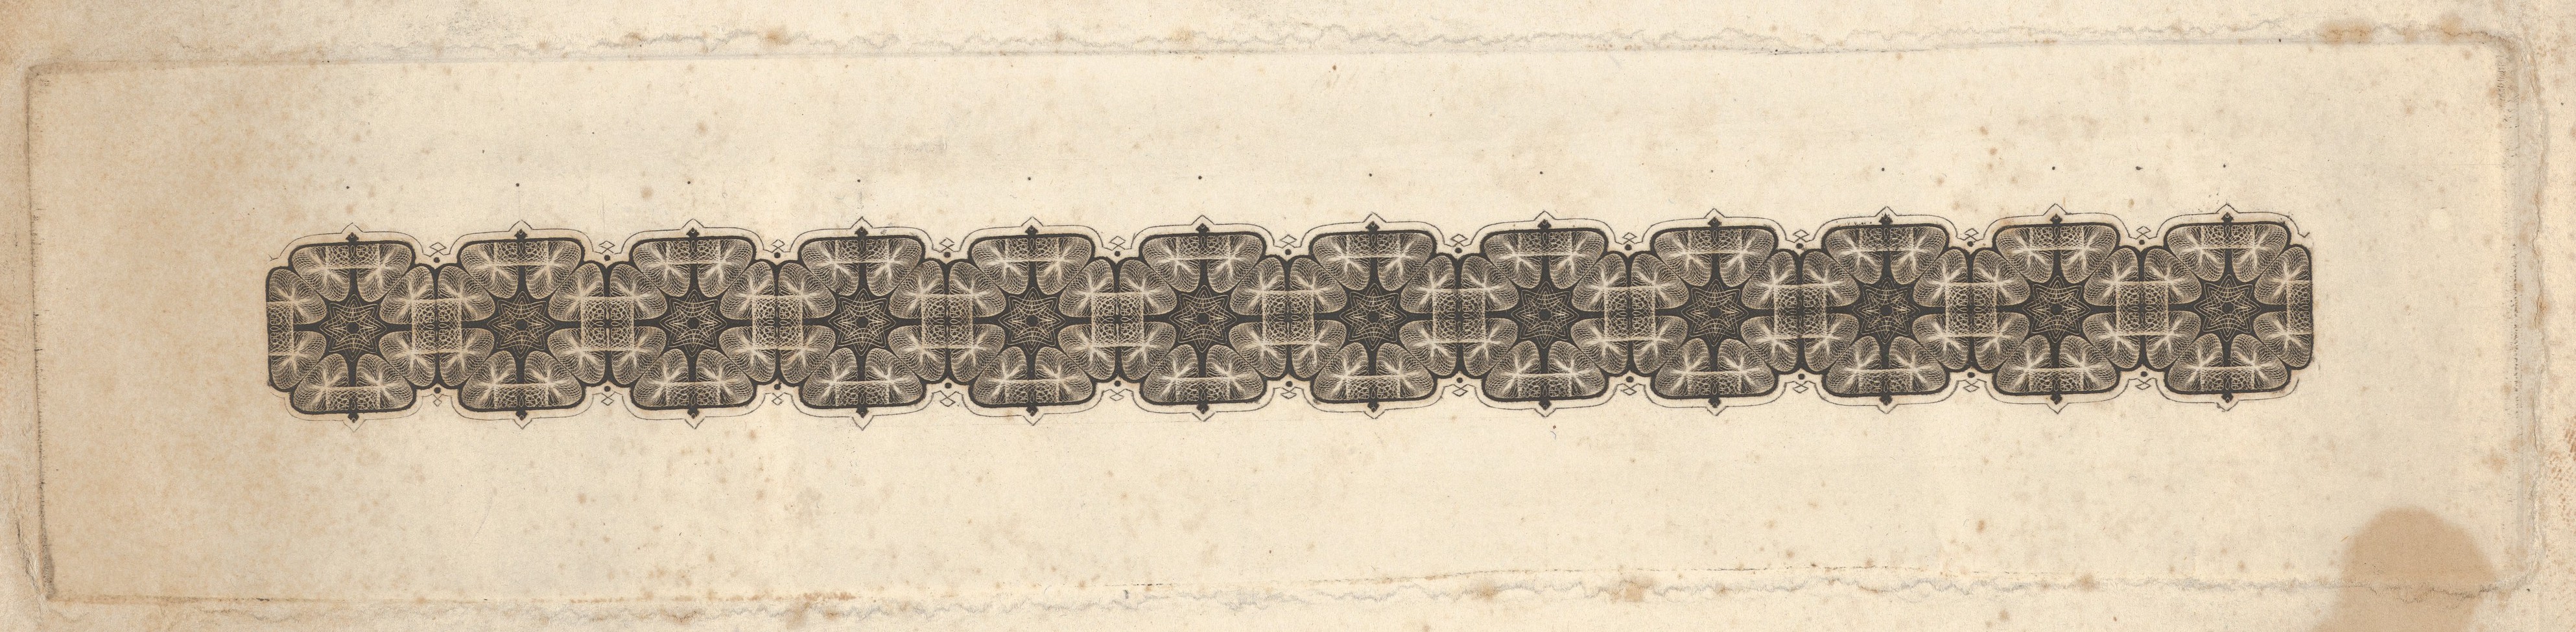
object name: print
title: Banknote motif: band of lathe work ornament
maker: cyrus durand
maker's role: artist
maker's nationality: american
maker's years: 1787-1868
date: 1824-1842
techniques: printmaking, engraving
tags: ornament